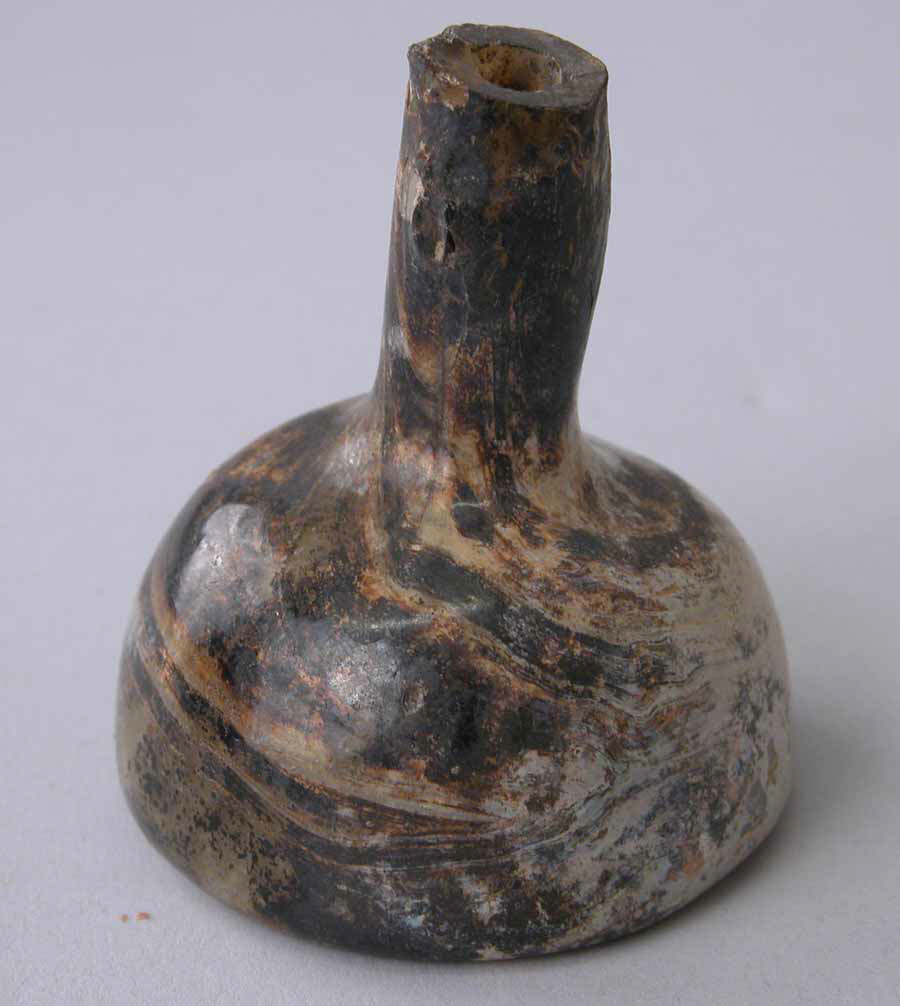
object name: bottle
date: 601-800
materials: glass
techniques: glassblowing, tooling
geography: iraq